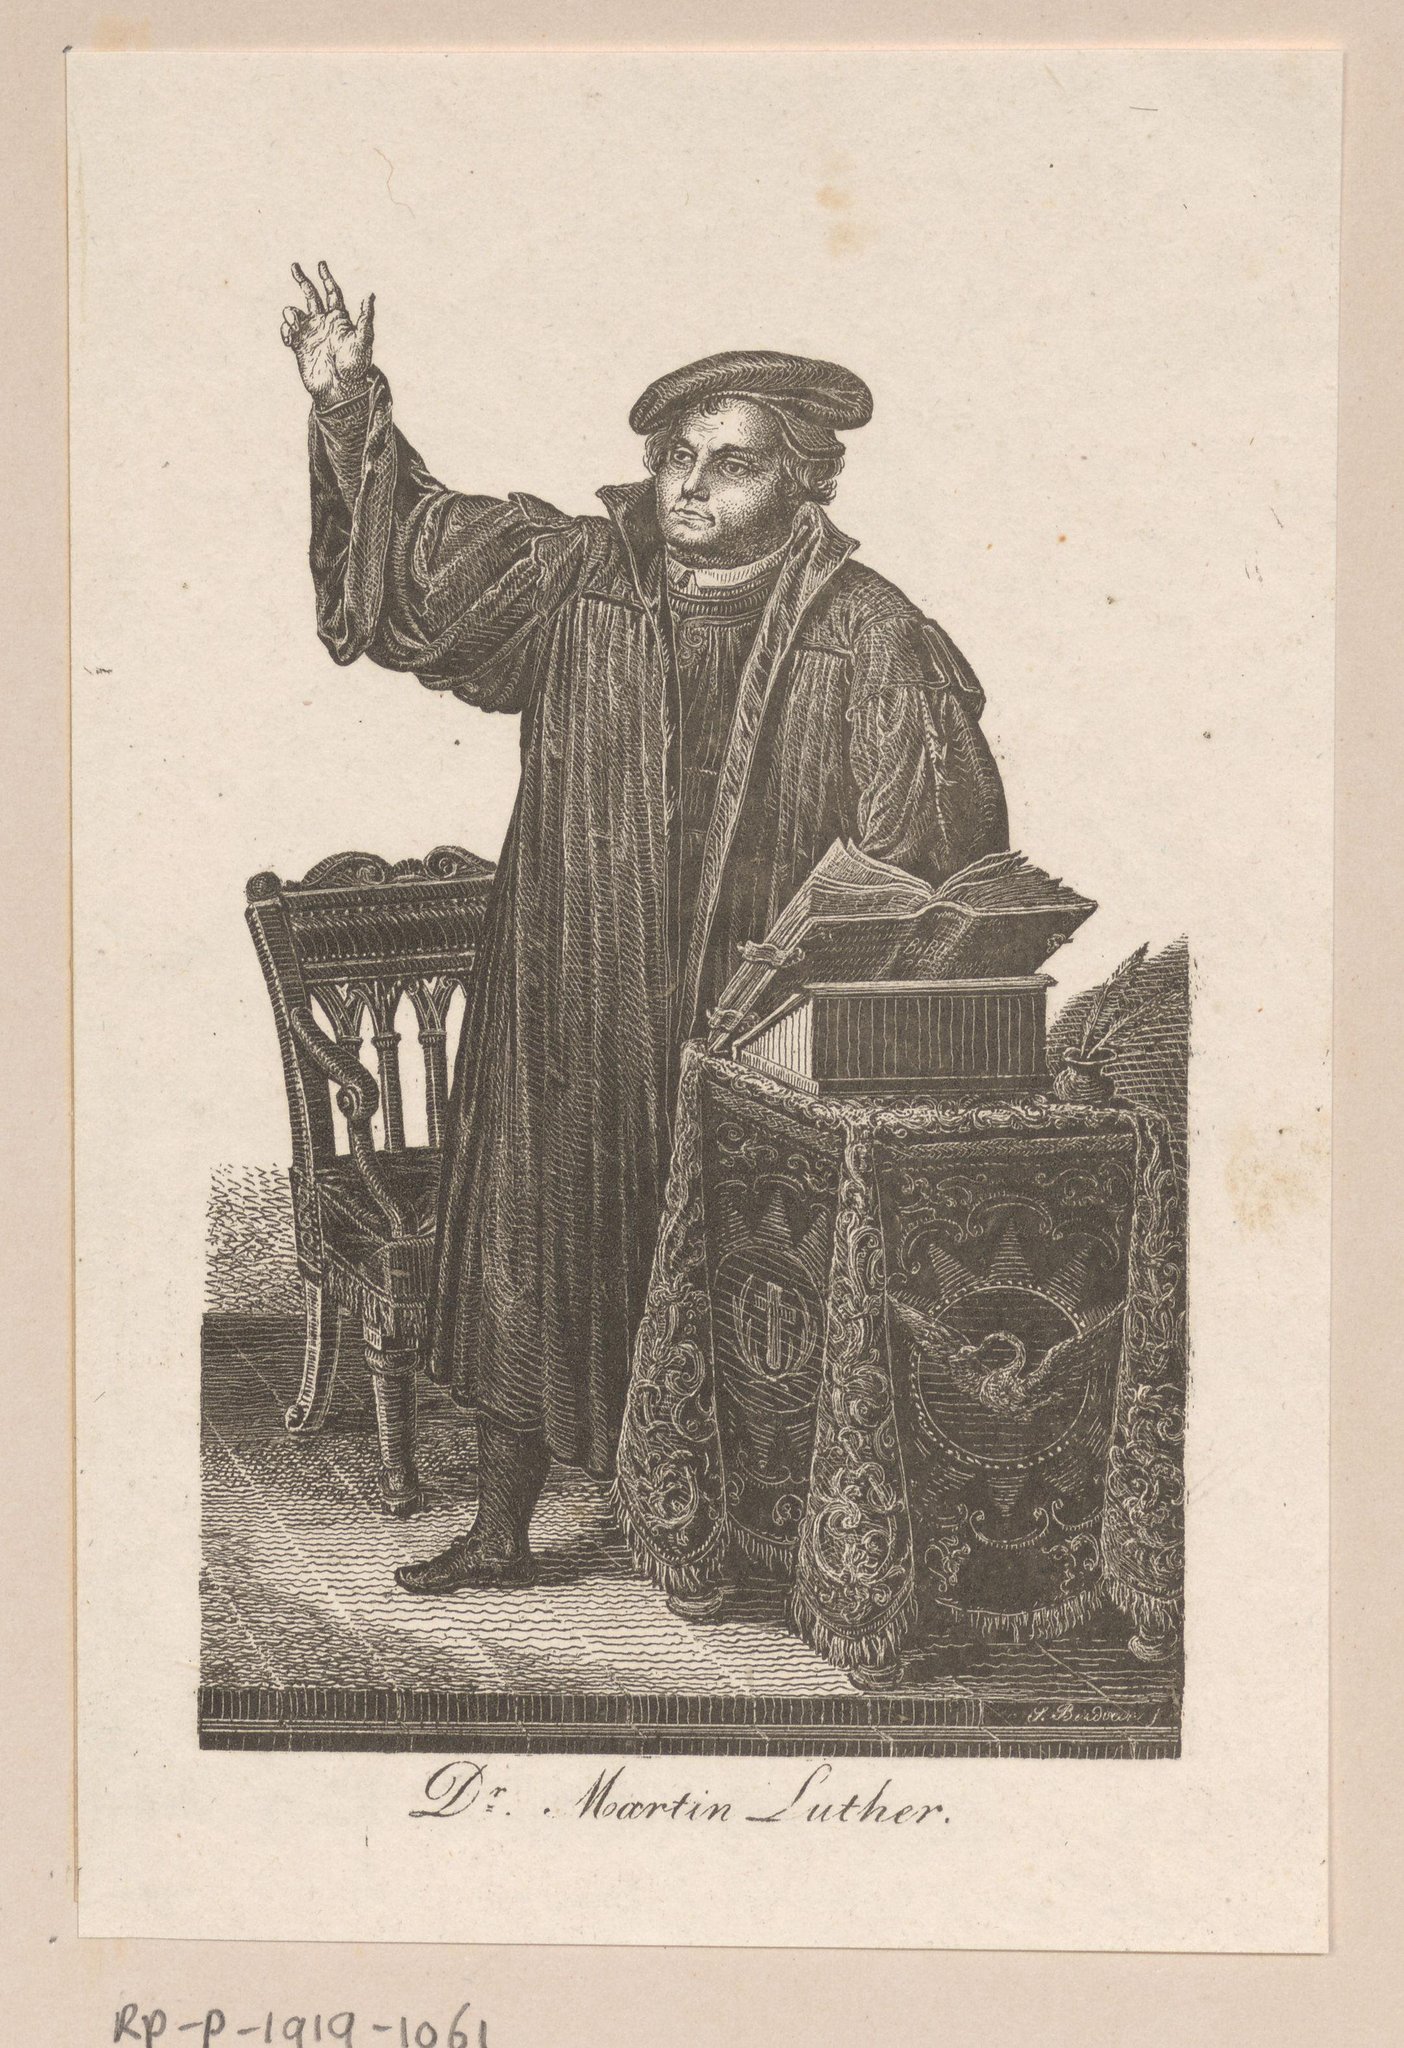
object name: print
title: Portret van Martin Luther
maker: Anonymous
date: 1800-1899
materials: paper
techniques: lithograph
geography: germany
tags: priest, martin luther, theologian, historical persons, book - mm - book open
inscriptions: signature: ‘S. [Bindixer?]’, collector's mark: Lugt 2228